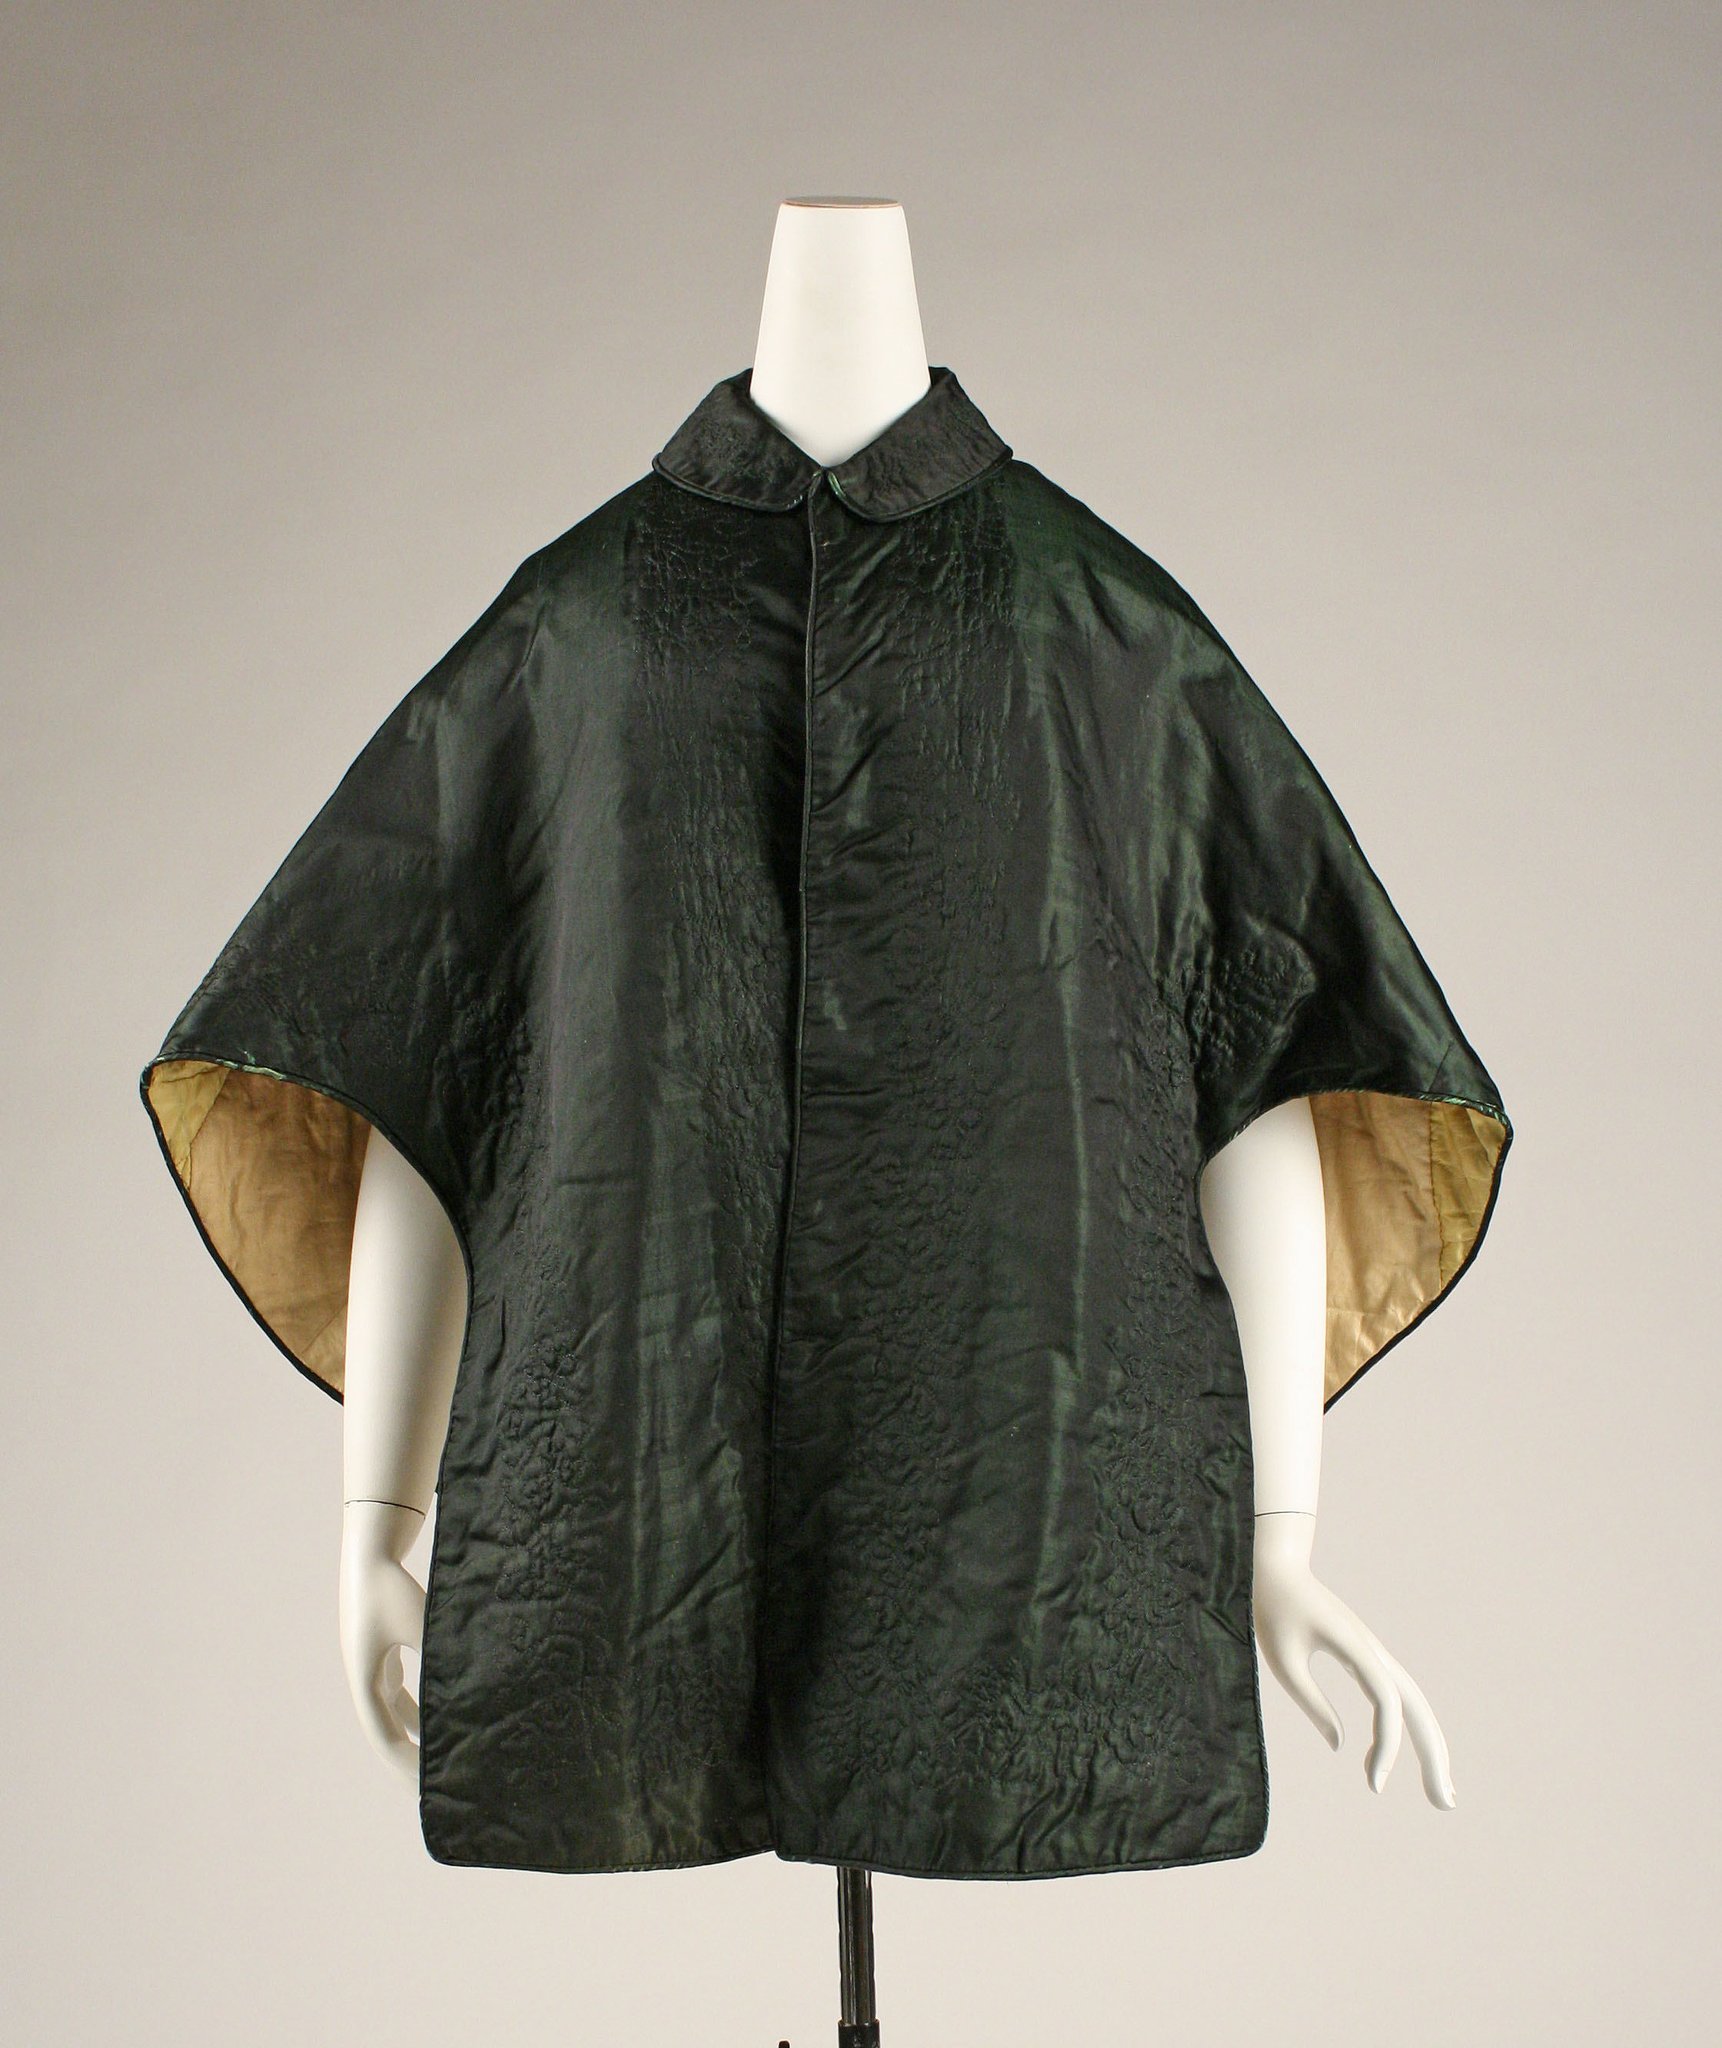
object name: mantle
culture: american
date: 1840-1869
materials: silk